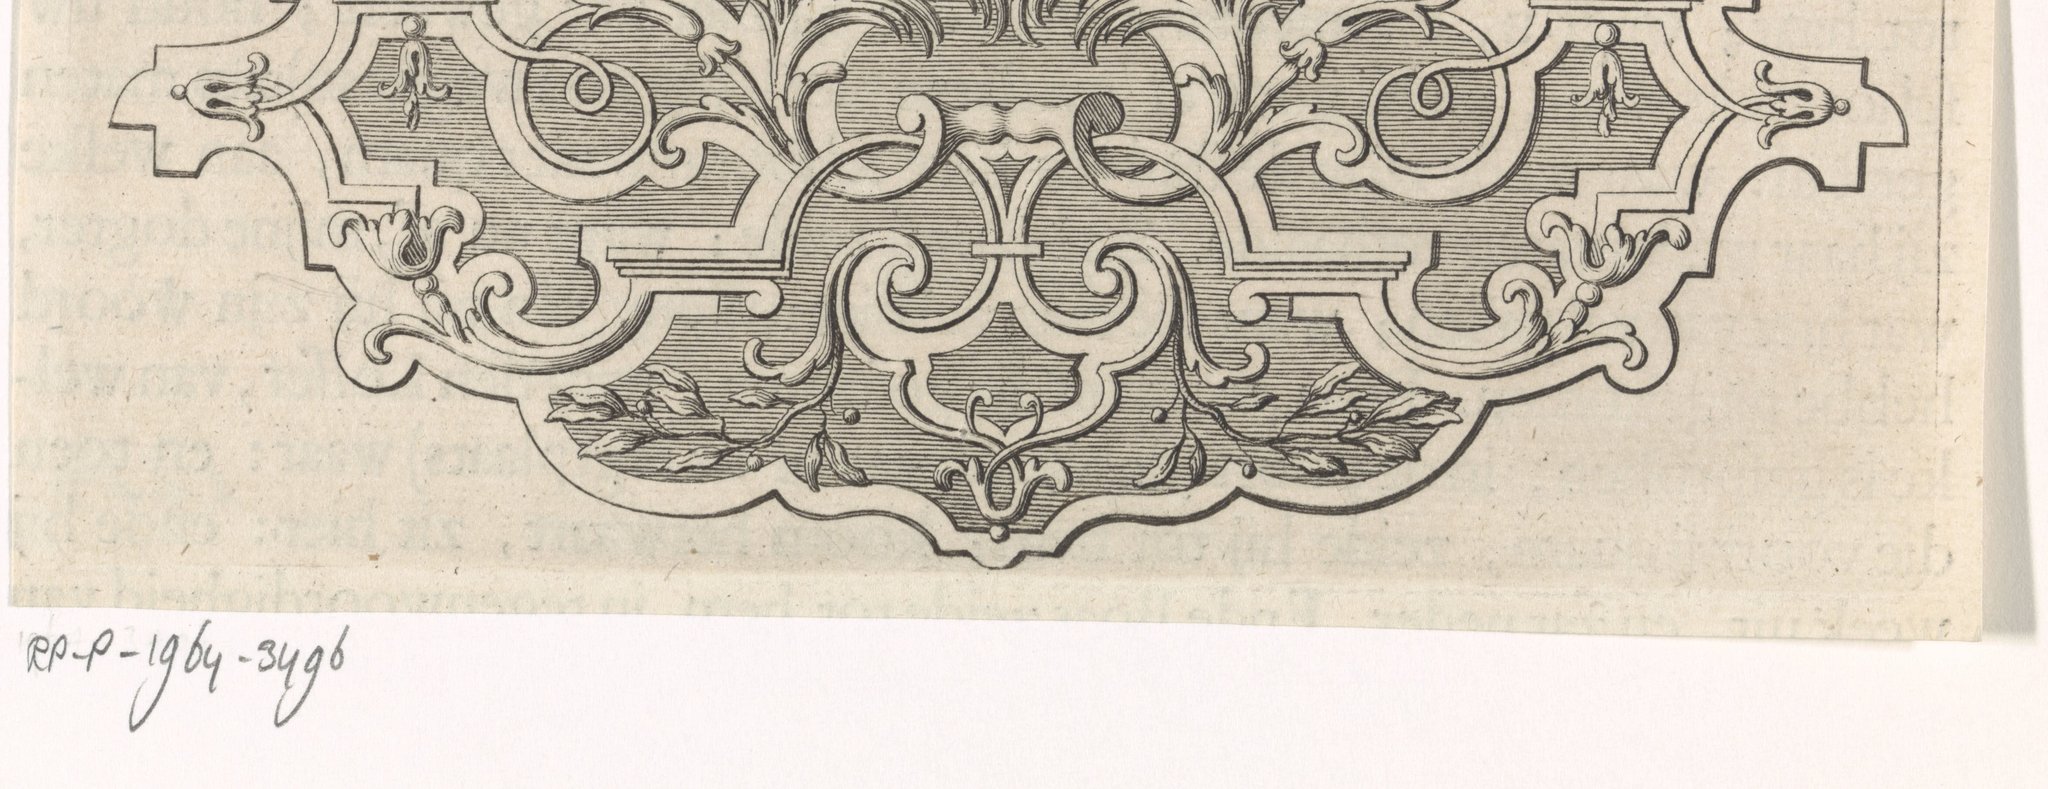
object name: print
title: Vignet met rolwerk en bladranken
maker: bernard picart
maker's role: draughtsman, print maker, publisher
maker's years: 1673-1733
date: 1683-1733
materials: paper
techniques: etching, letterpress printing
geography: amsterdam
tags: scrollwork, strapwork ~ ornament, foliage, tendrils, branches ~ ornament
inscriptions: collector's mark: Lugt 2228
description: Prent oorspronkelijk bedoeld voor: Figures de la Bible. Amsterdam, Bernard Picart, 1720. Prent ook gebruikt in: Taferelen der voornaamste geschiedenissen van het Oude en Nieuwe Testament (...) door de vermaarde kunstenaars Hoet, Houbraken, en Picart getekent (...) en met beschrijvingen uitgebreid. Den Haag: Pieter de Hondt, 1728. Prent kan mogelijk ook zijn gebruikt in andere bijbels.